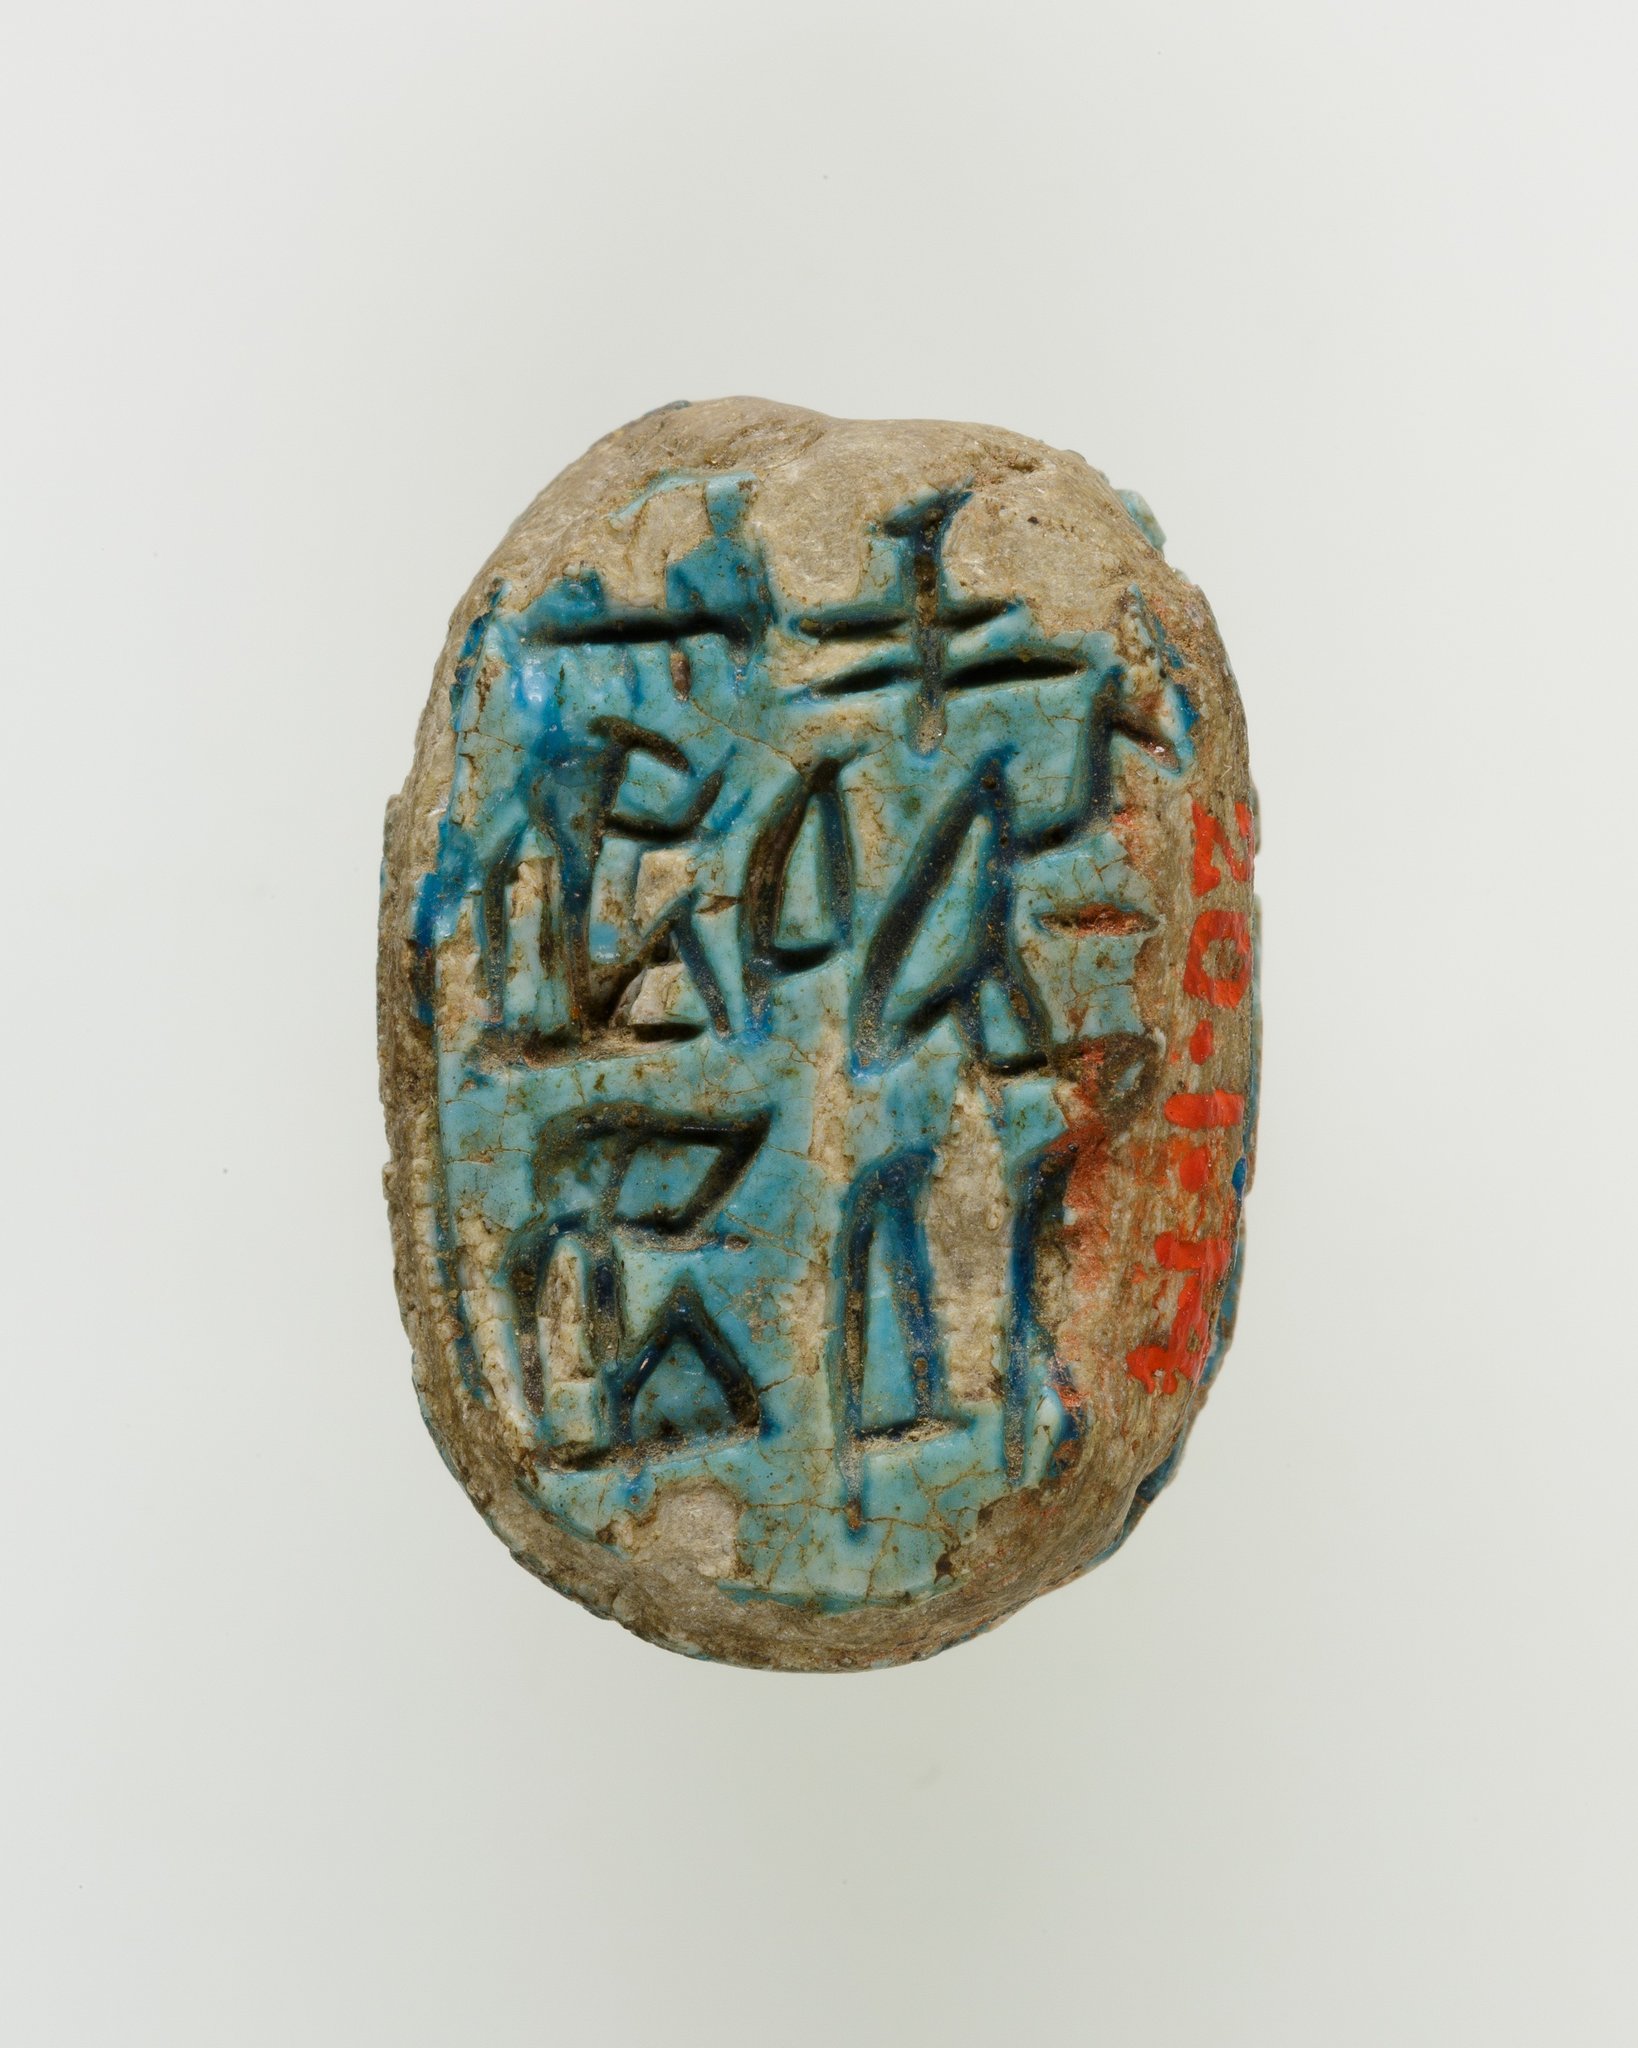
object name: scarab, queen aty ity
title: Scarab of Queen Ity (Aty)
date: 1802-1676 BCE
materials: stone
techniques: glazing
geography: egypt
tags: scarabs